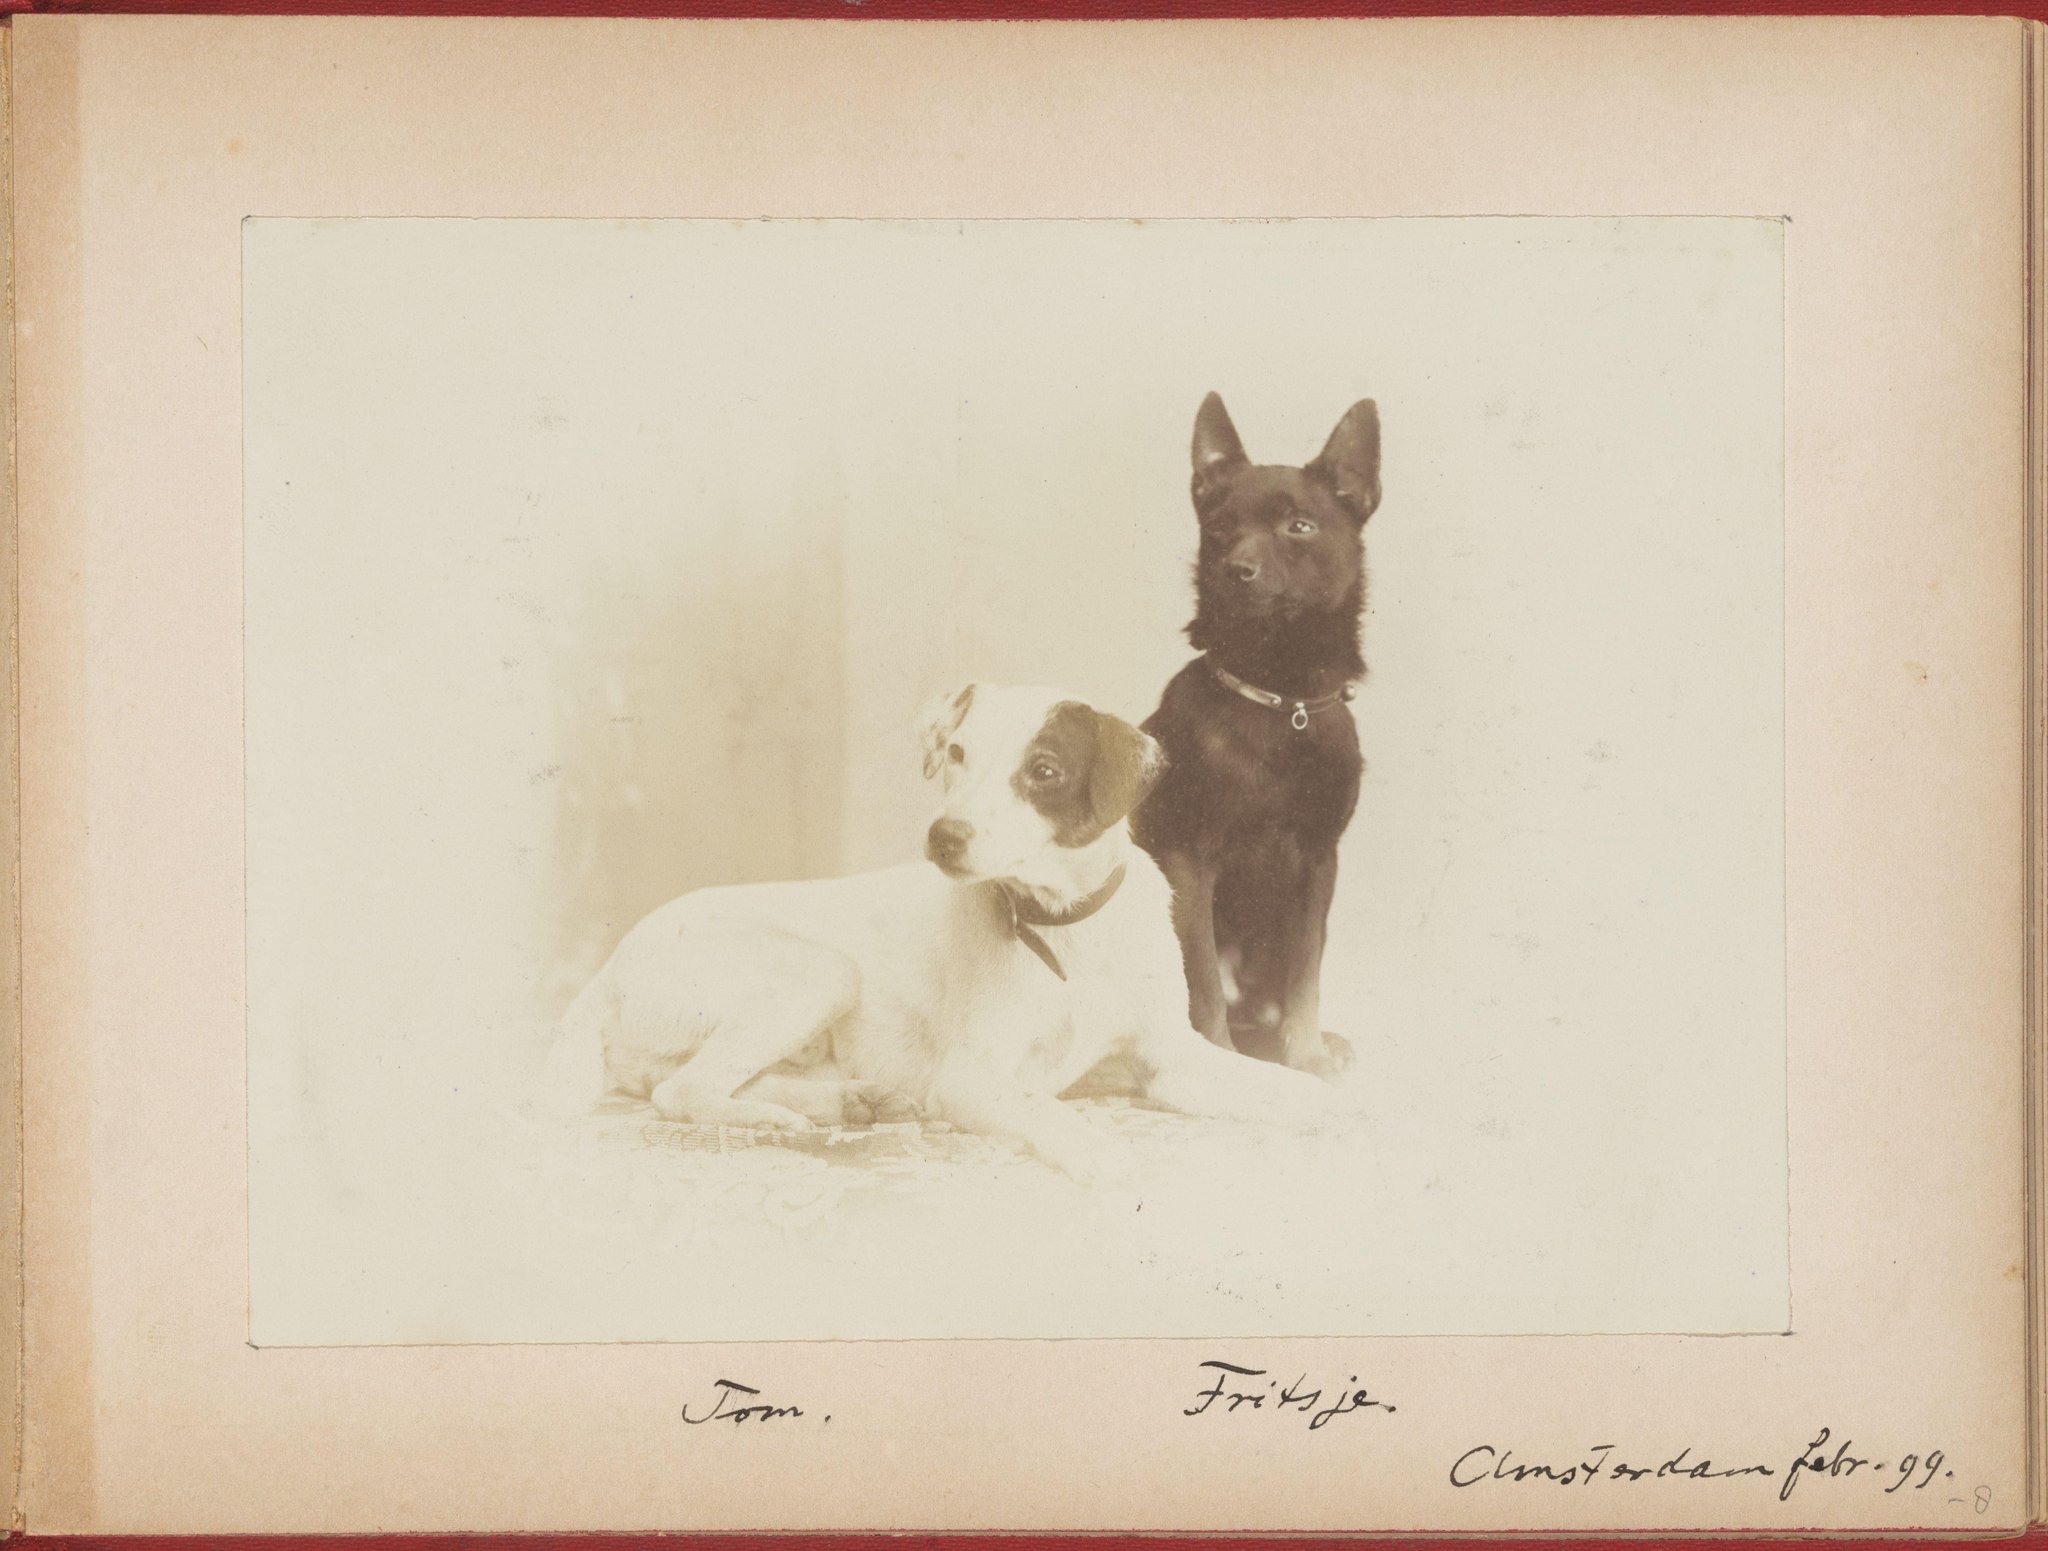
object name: photograph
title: Portret van de honden Tom en Fritsje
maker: gerard aalbersberg (us)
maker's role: amateurfotograaf, arts, chirurg, gynaecoloog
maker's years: 1870-1934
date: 1802-1899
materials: paper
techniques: matte daylight collodion silver print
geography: amsterdam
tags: amsterdam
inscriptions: title: ‘Tom Fritsje. Amsterdam febr. 99.’